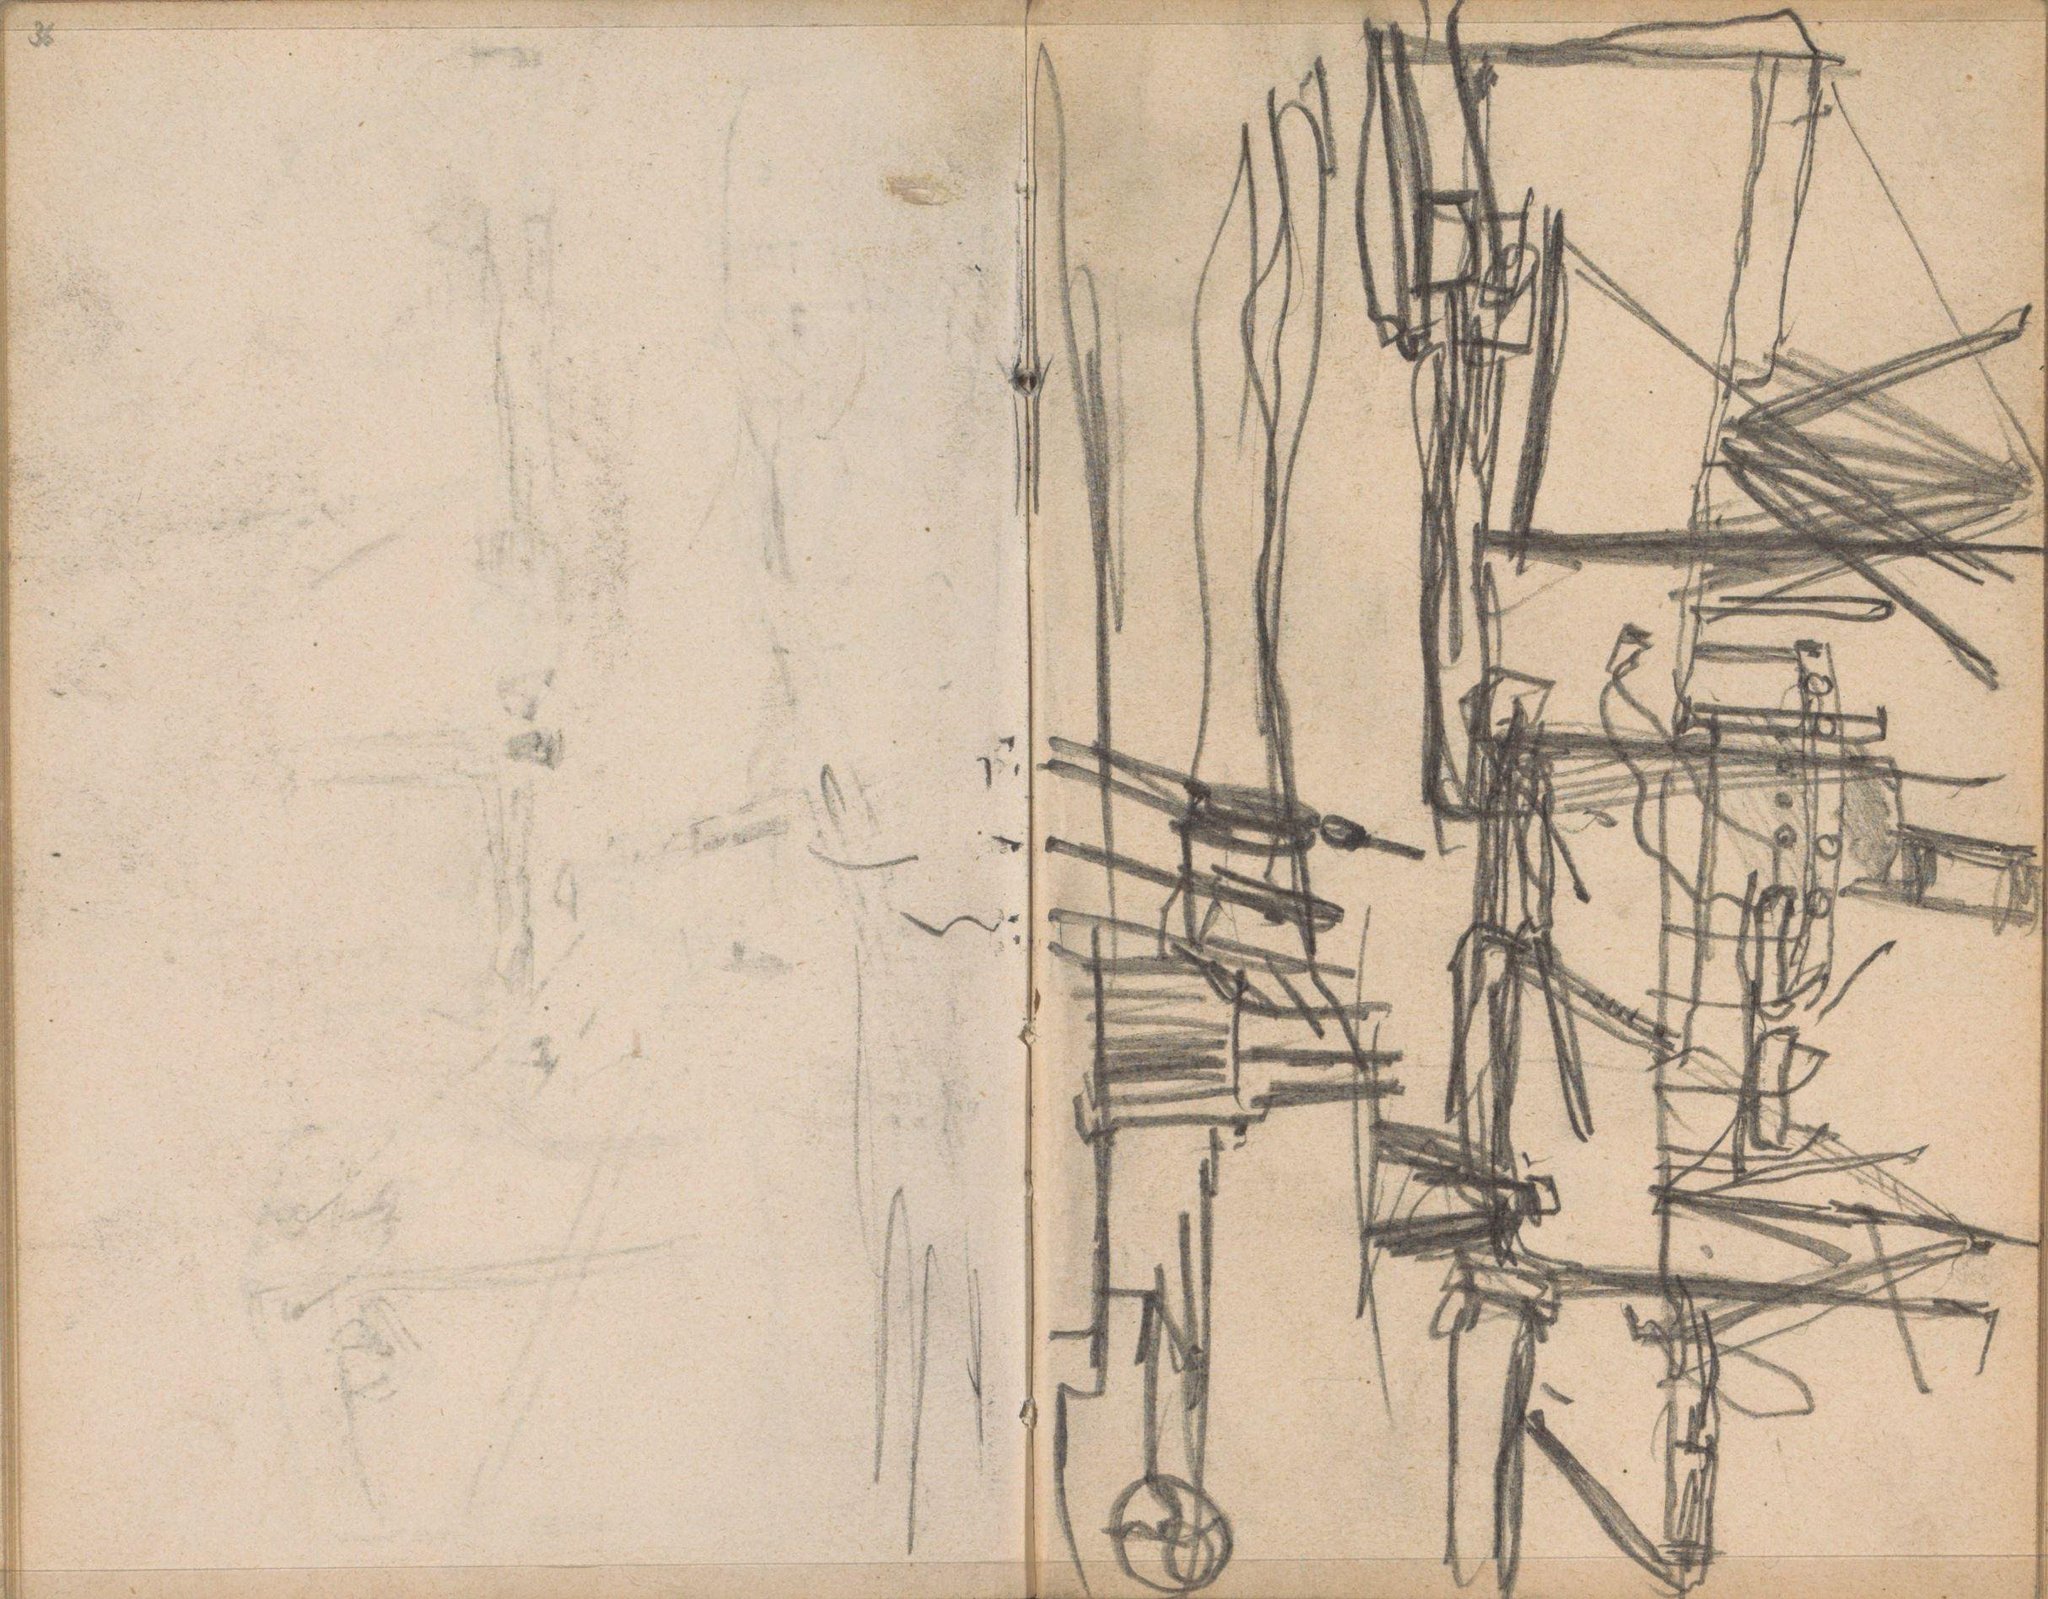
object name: sketchbook leaf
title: Stoomboot op het IJ ter hoogte van de Barentszkade te Amsterdam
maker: george hendrik breitner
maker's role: draughtsman, painter, print maker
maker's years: 1857-1923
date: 1892-1923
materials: paper, pencil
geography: amsterdam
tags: machine driven by steam, ships (in general)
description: Stoomboot op het IJ ter hoogte van de Barentszkade te Amsterdam. Pagina 36 en pagina 37 uit een schetsboek met 45 bladen vervaardigd te Schwerin en Amsterdam.